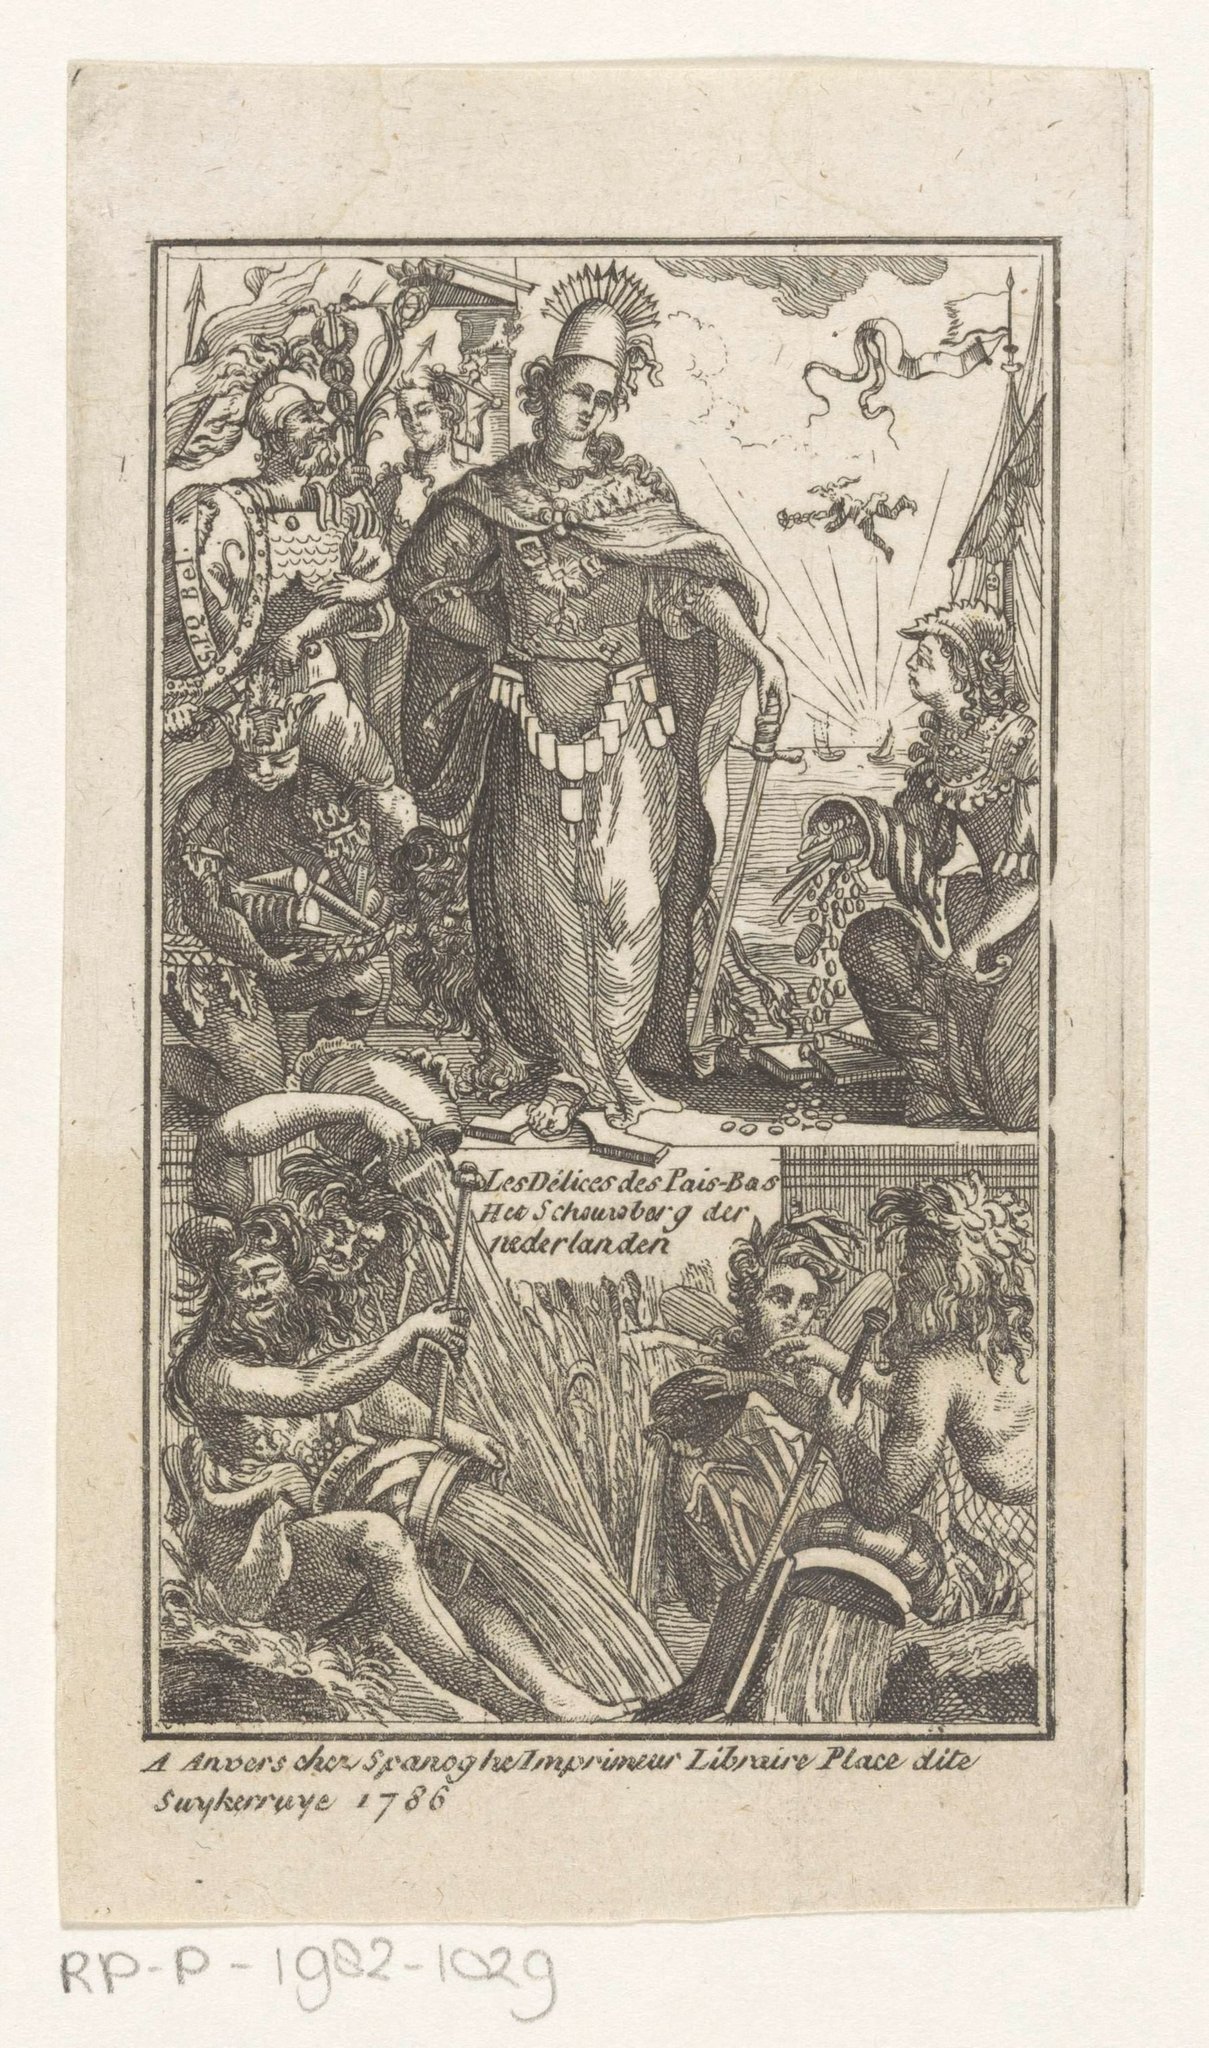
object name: print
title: Titelpagina voor: Jean Baptiste Christyn, Les Délices des Pais-Bas (...), 1786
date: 1786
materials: paper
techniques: engraving, etching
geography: antwerp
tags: personifications of countries, nations, states, districts, etc., low countries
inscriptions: collector's mark: Lugt 2228, collector's mark: Lugt 2760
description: In het midden staat een personificatie van de Nederlanden met een zwaard en een helm met zeventien pijlen (de Zeventien Provinciën) op het hoofd. Achter haar ligt de Nederlandse leeuw. Rechts van haar zit een vrouw met hoorn des overvloeds. Links van haar drie personificaties. Aan de onderzijde zitten personificaties van de rivieren de Schelde, de Maas en de Rijn. Rechts in de achtergrond vliegt Mercurius.